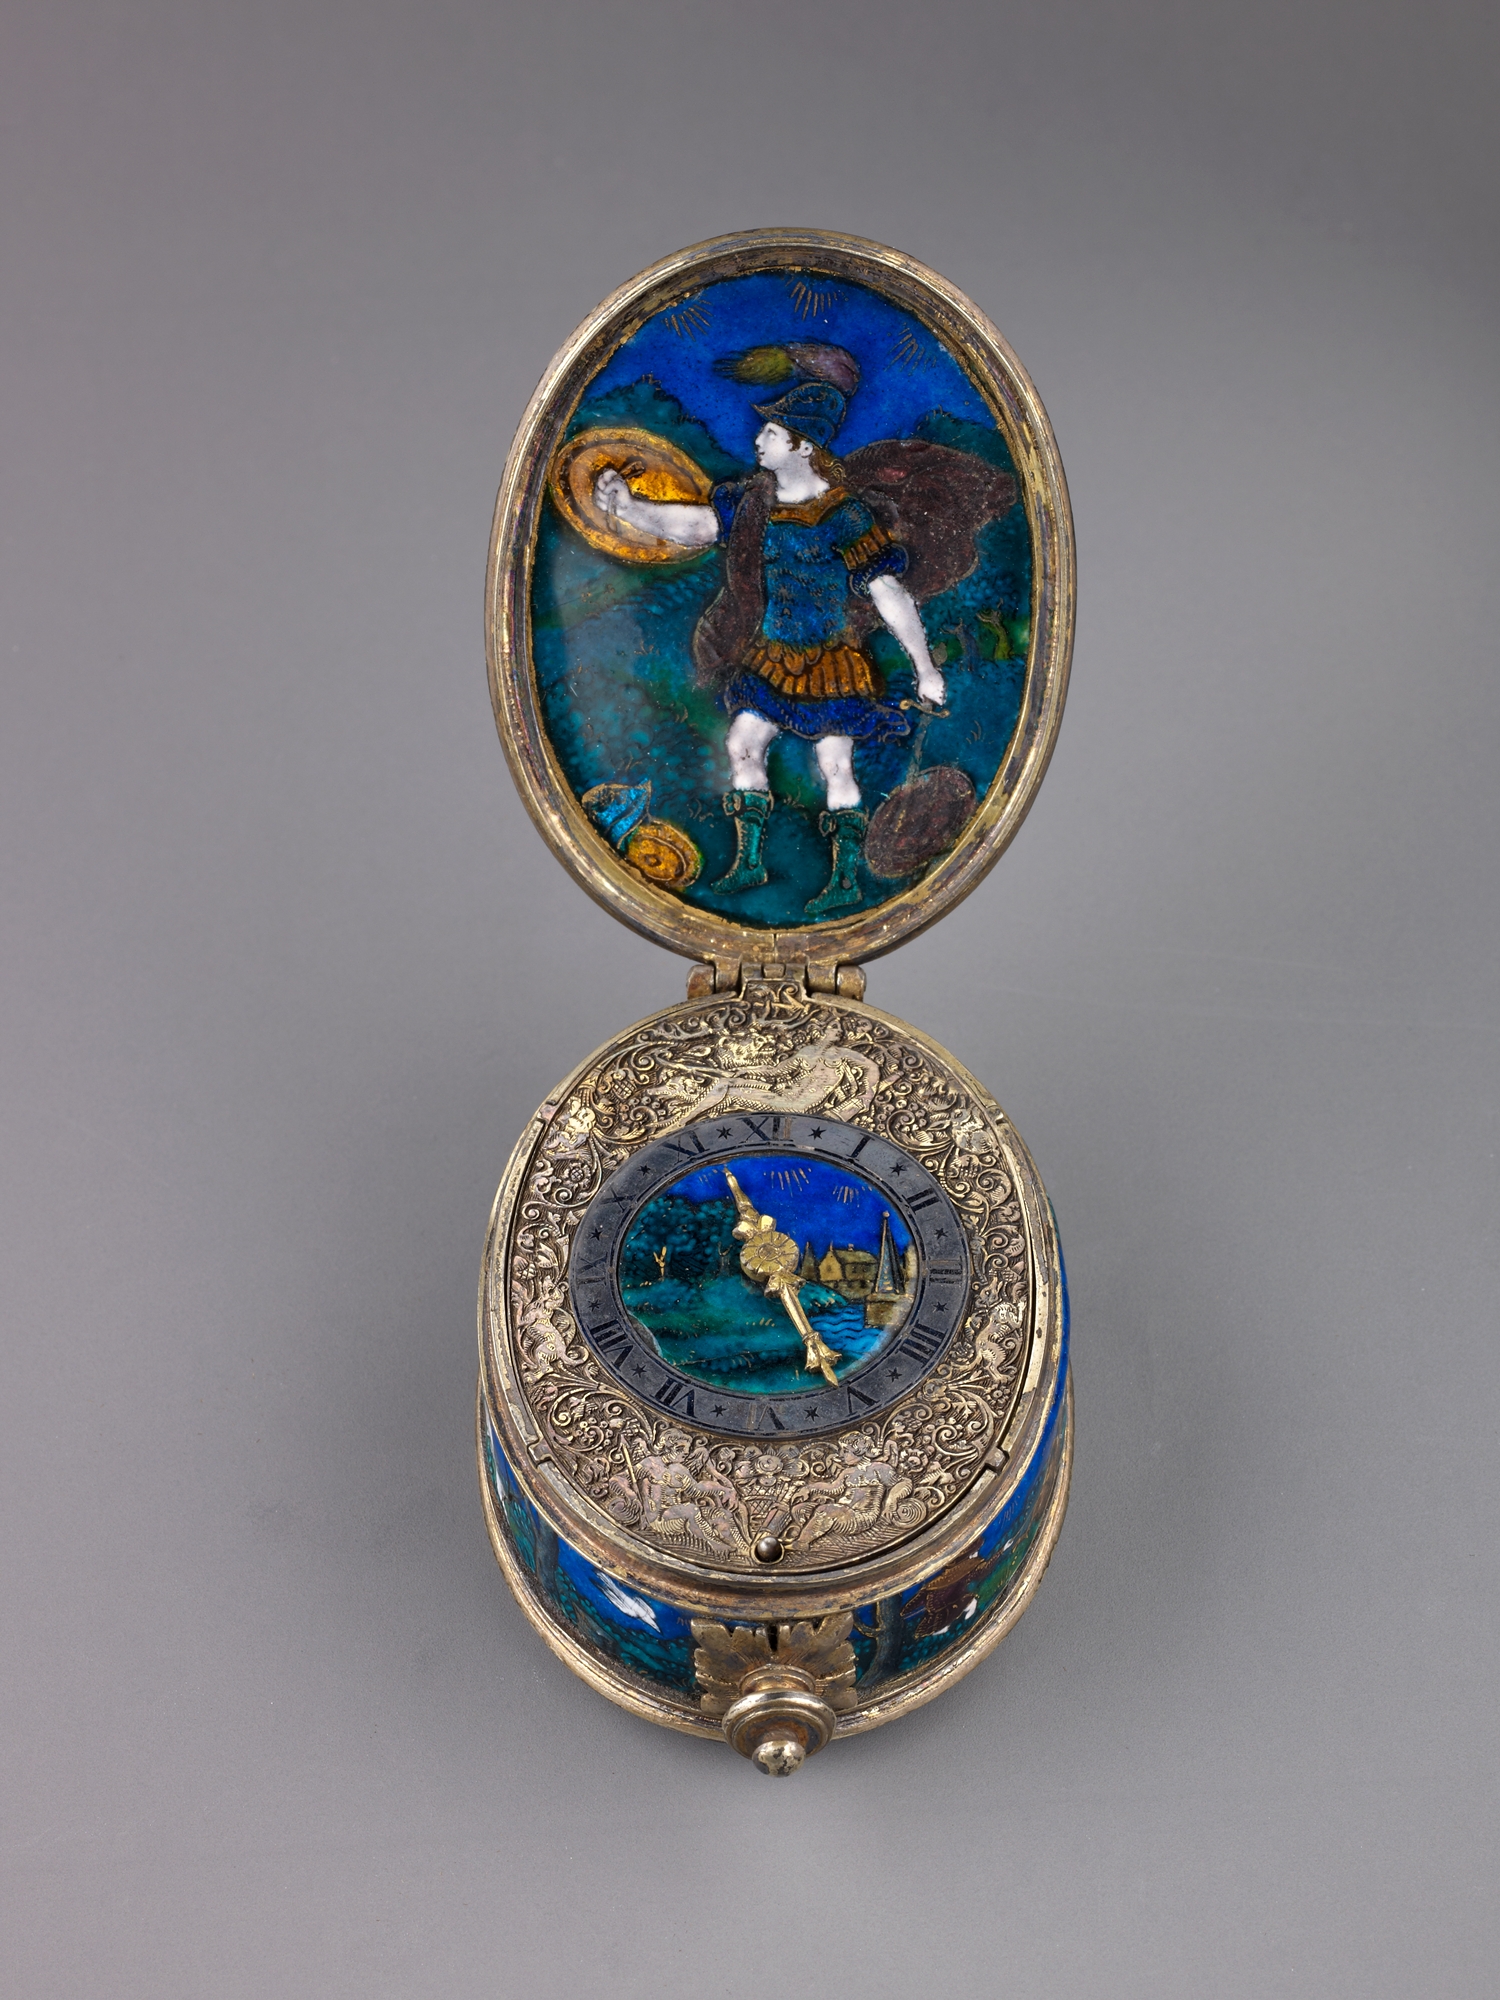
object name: watch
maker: suzanne de court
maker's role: artist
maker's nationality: french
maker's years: 1575-1625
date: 1601-1625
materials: brass, copper, enamel, gilt, silver, silver gilt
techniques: gilding, painting, silvered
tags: men